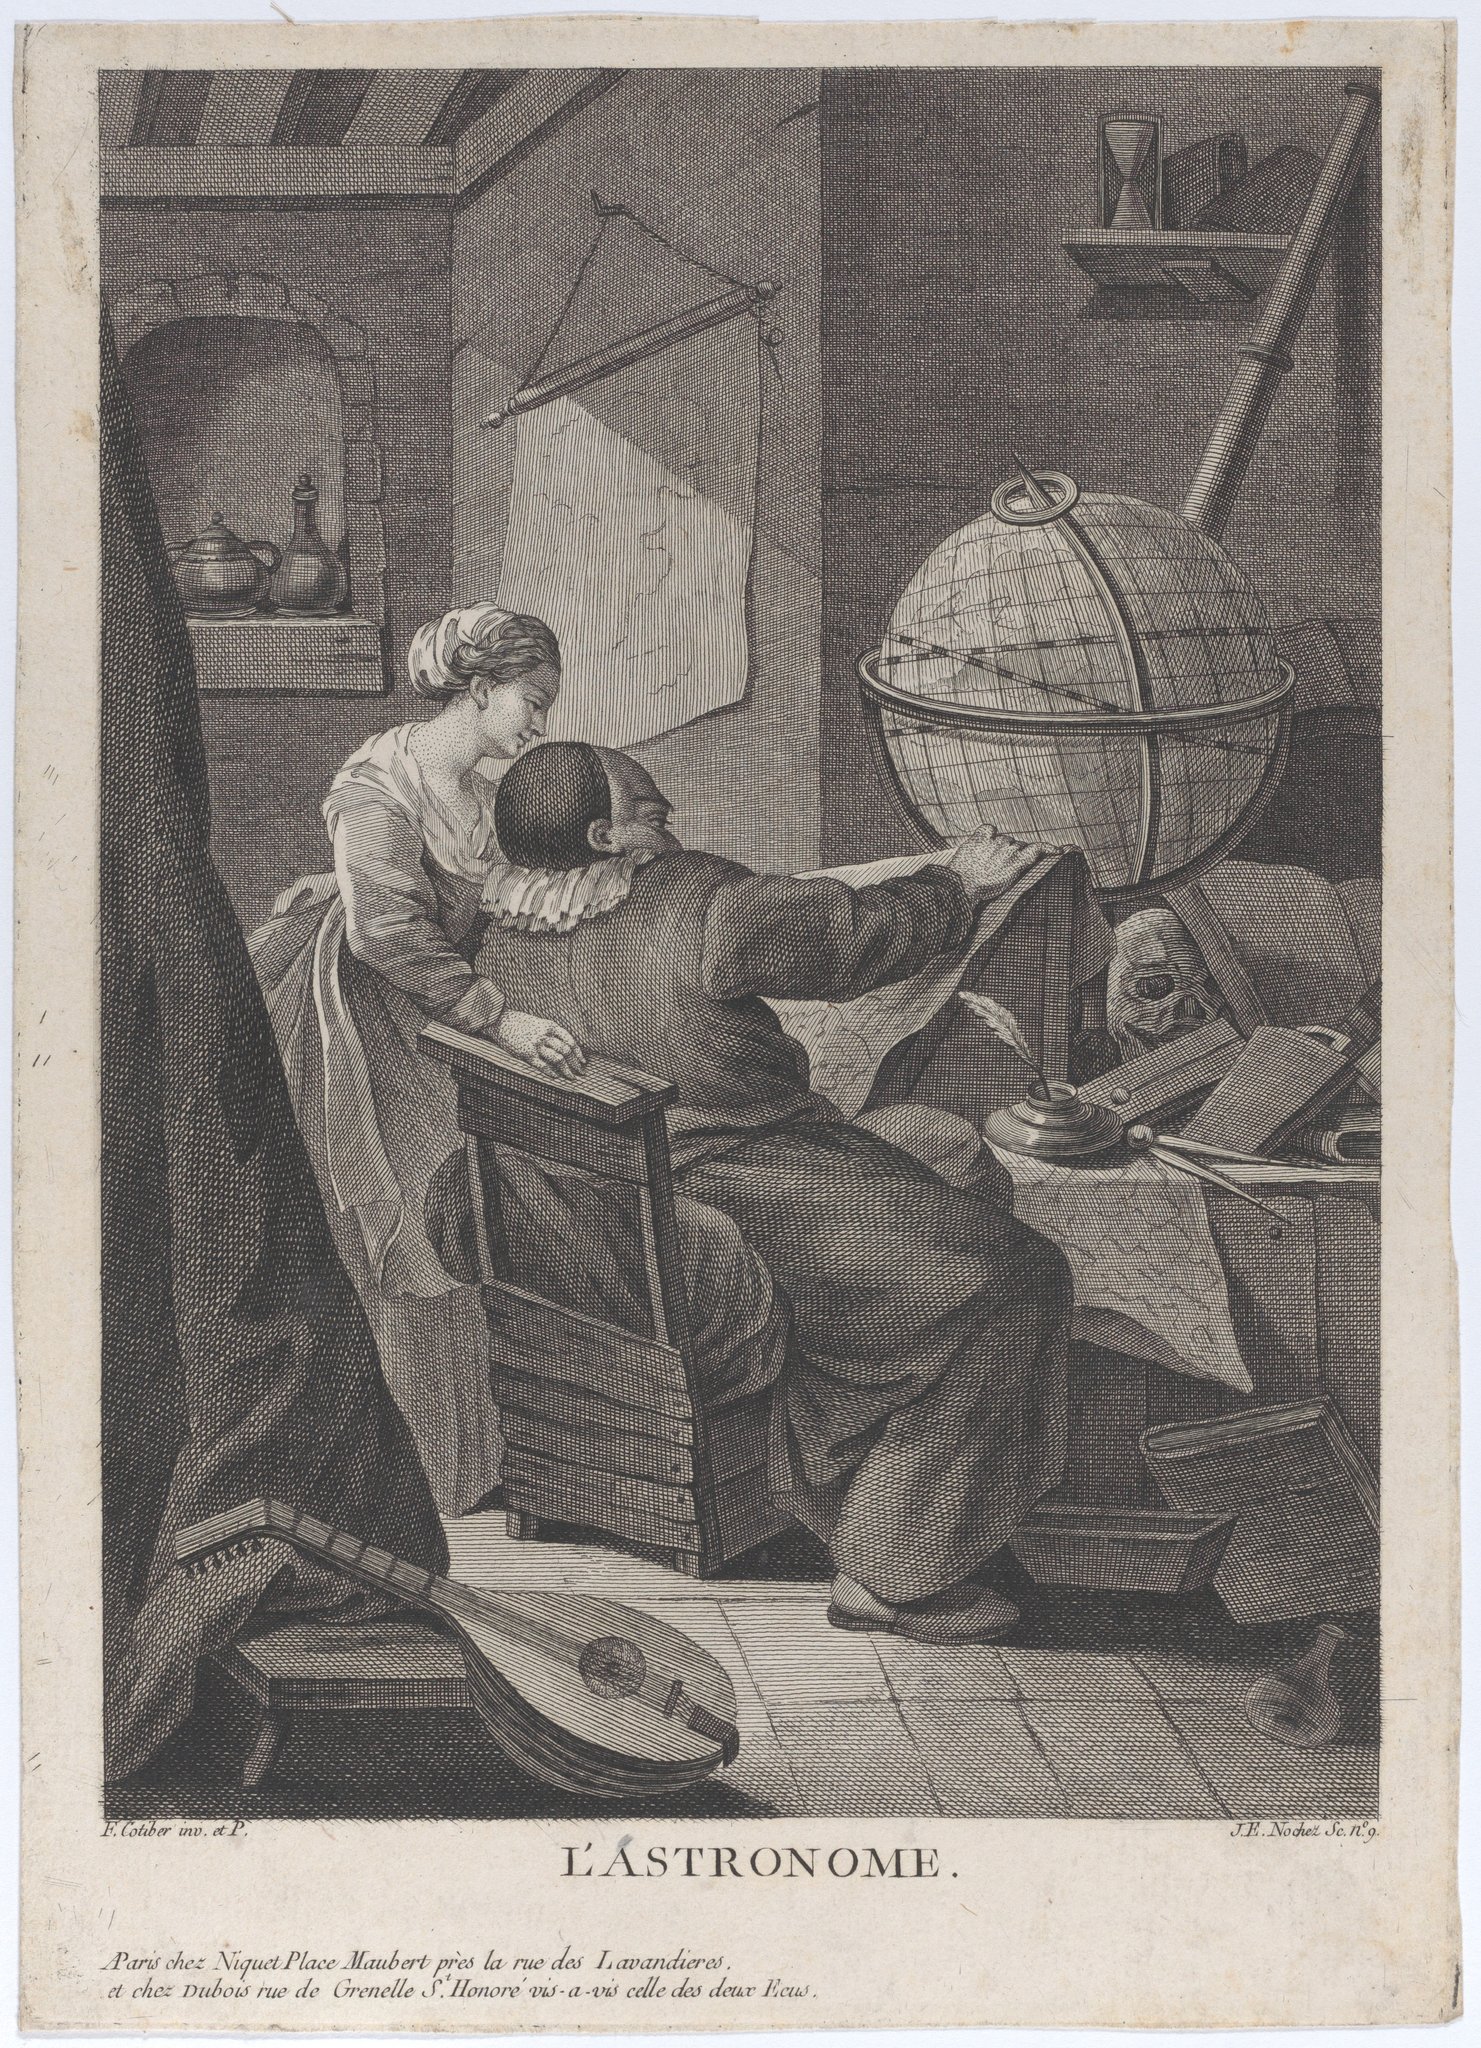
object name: print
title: L'Astronome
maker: jean edme nochez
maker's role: artist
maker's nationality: french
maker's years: 1736-1800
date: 1750-1800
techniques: etching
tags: men,women,astronomy,globes